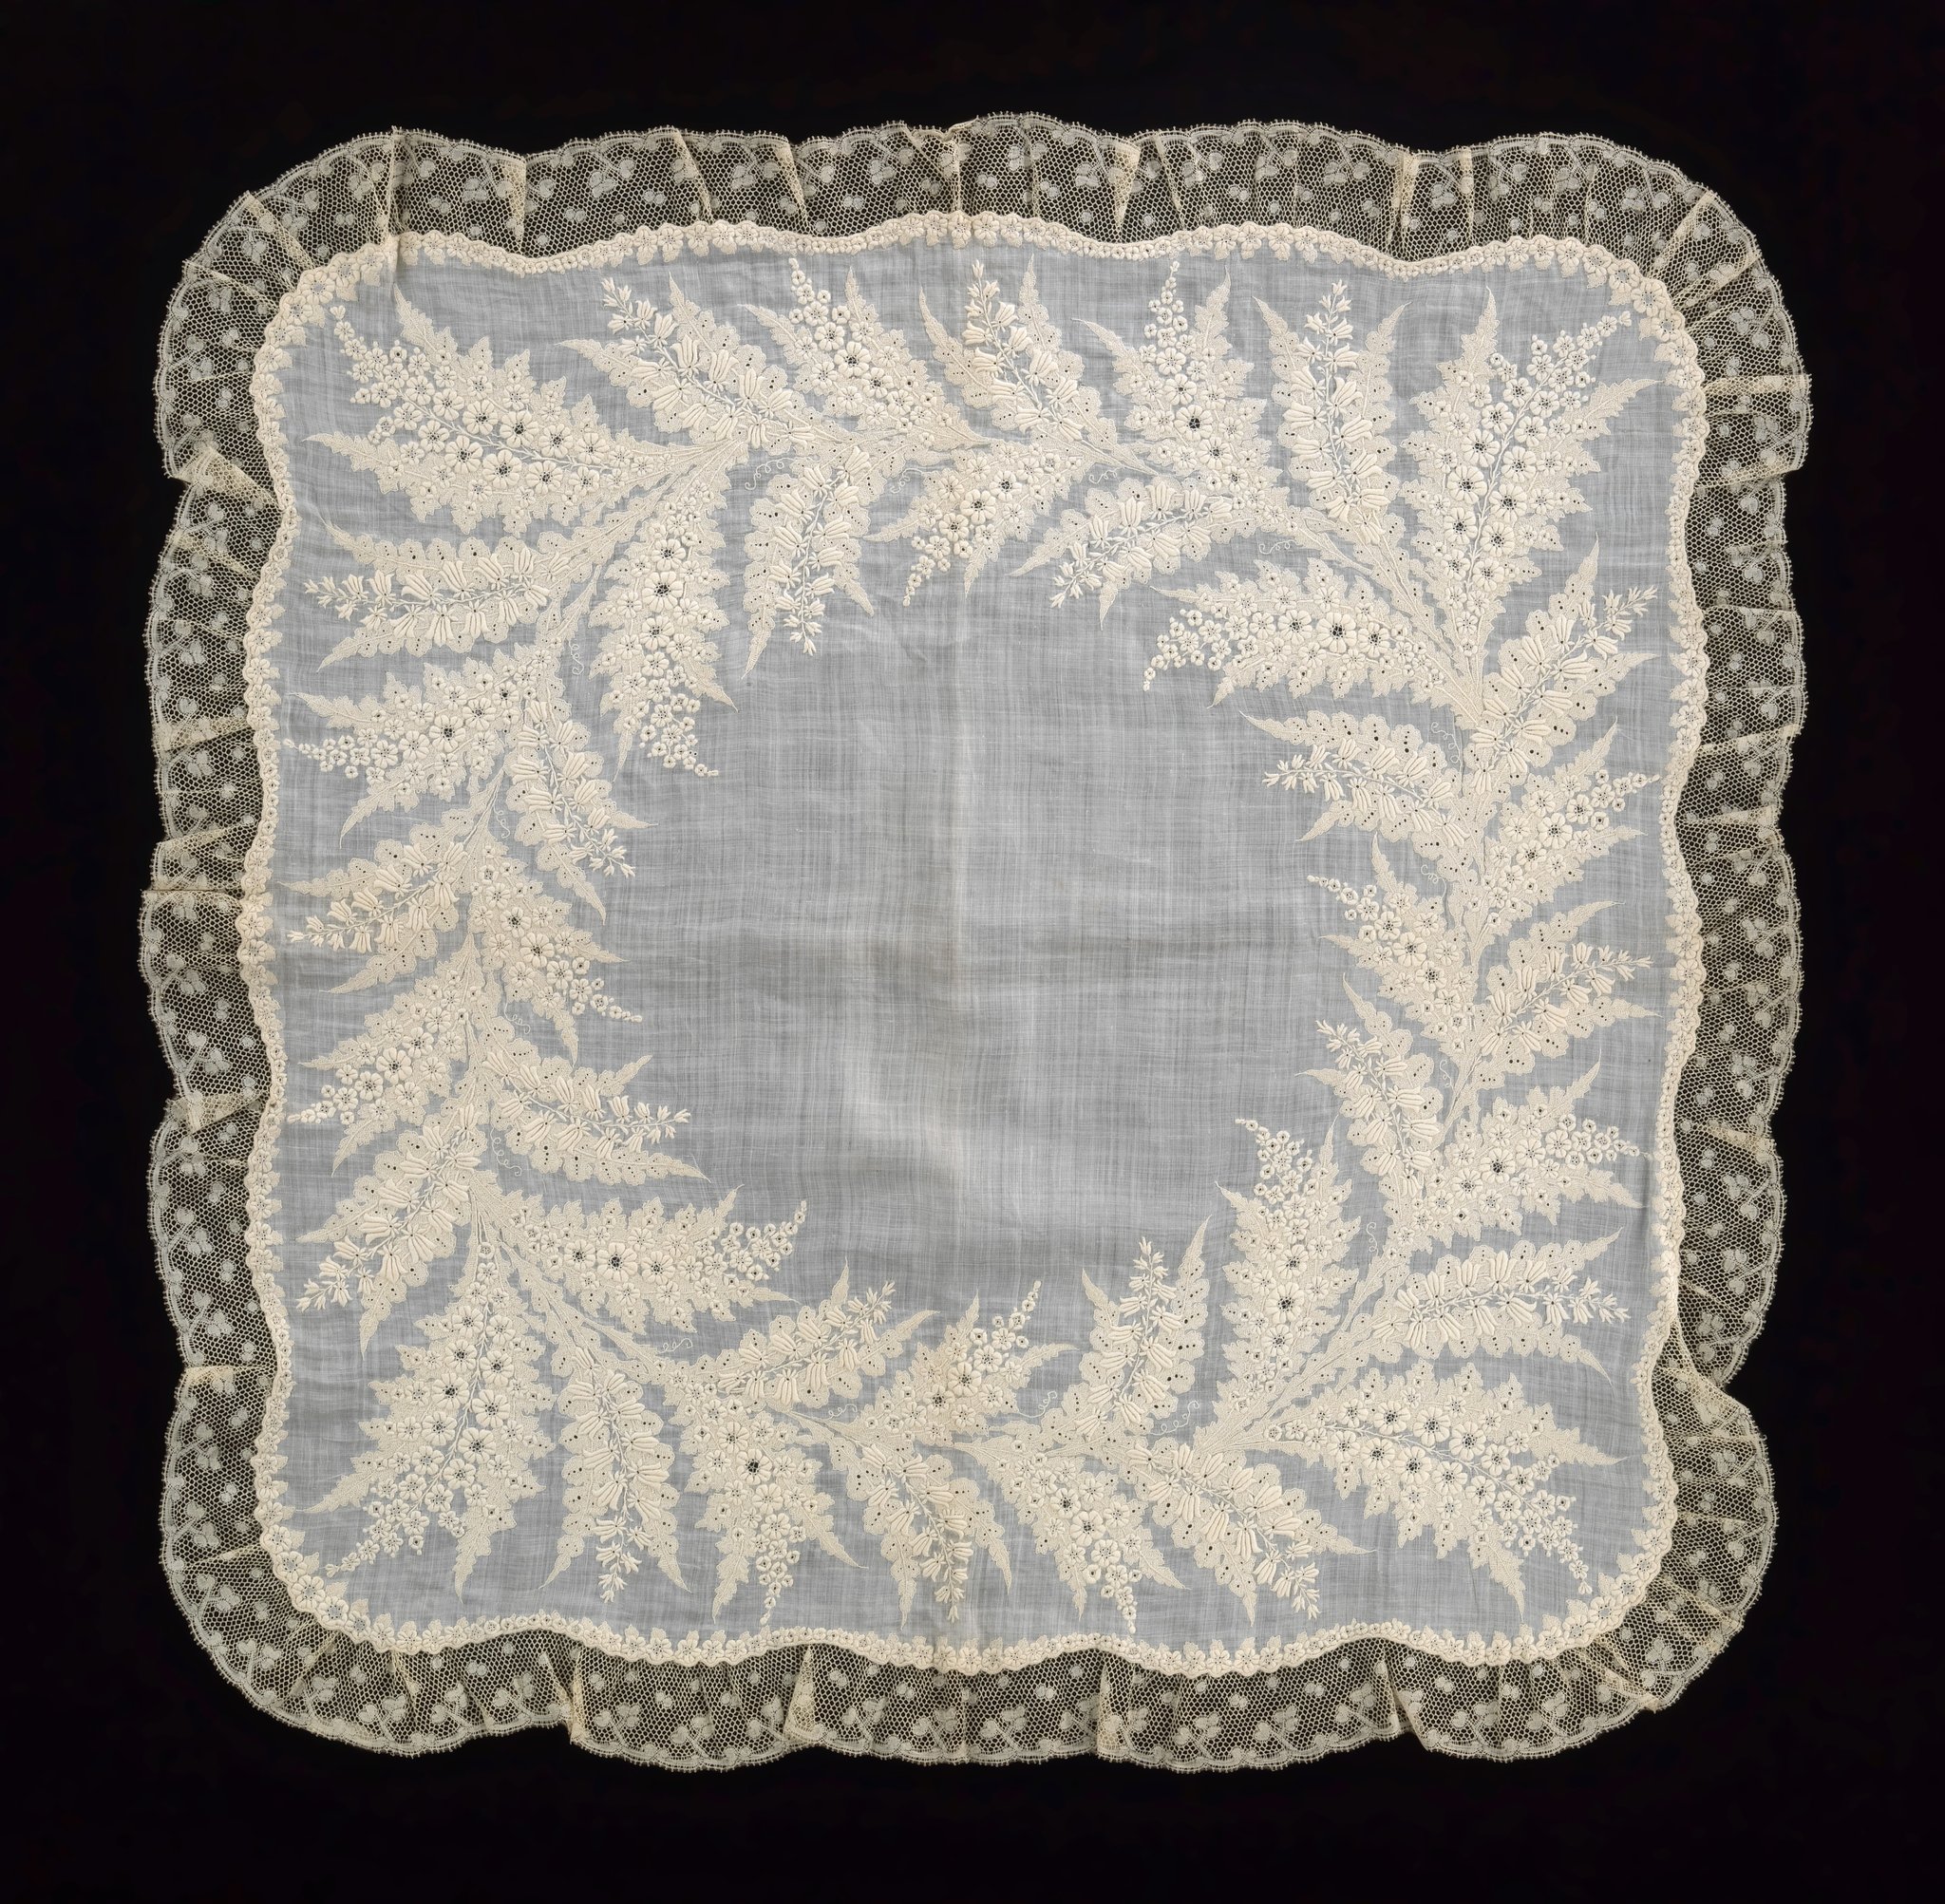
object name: handkerchief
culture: french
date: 1850-1860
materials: linen